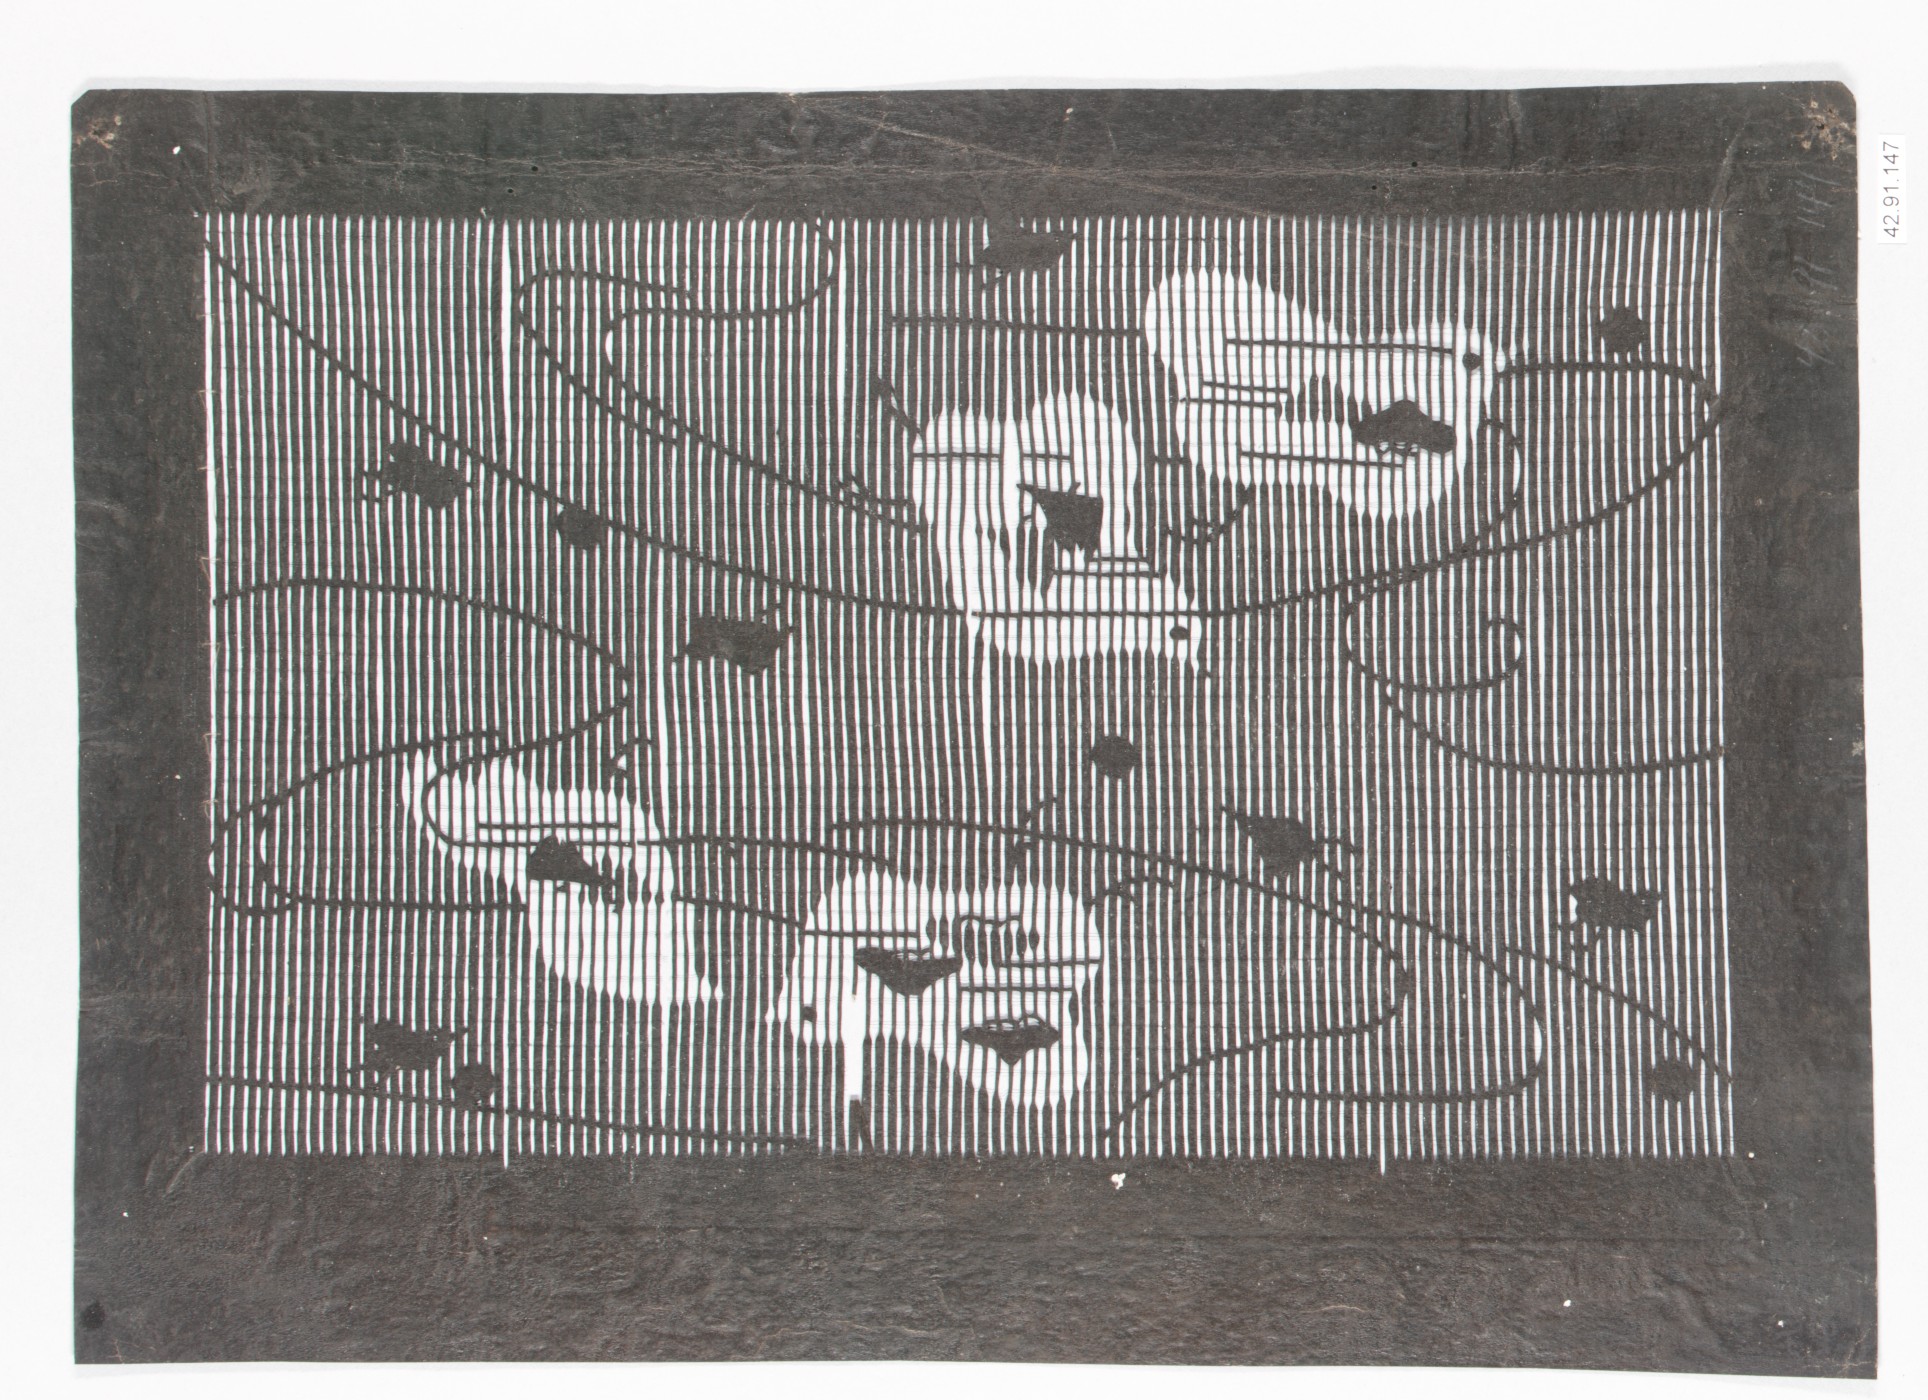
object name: stencil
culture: japanese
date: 1801-1900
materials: paper, silk